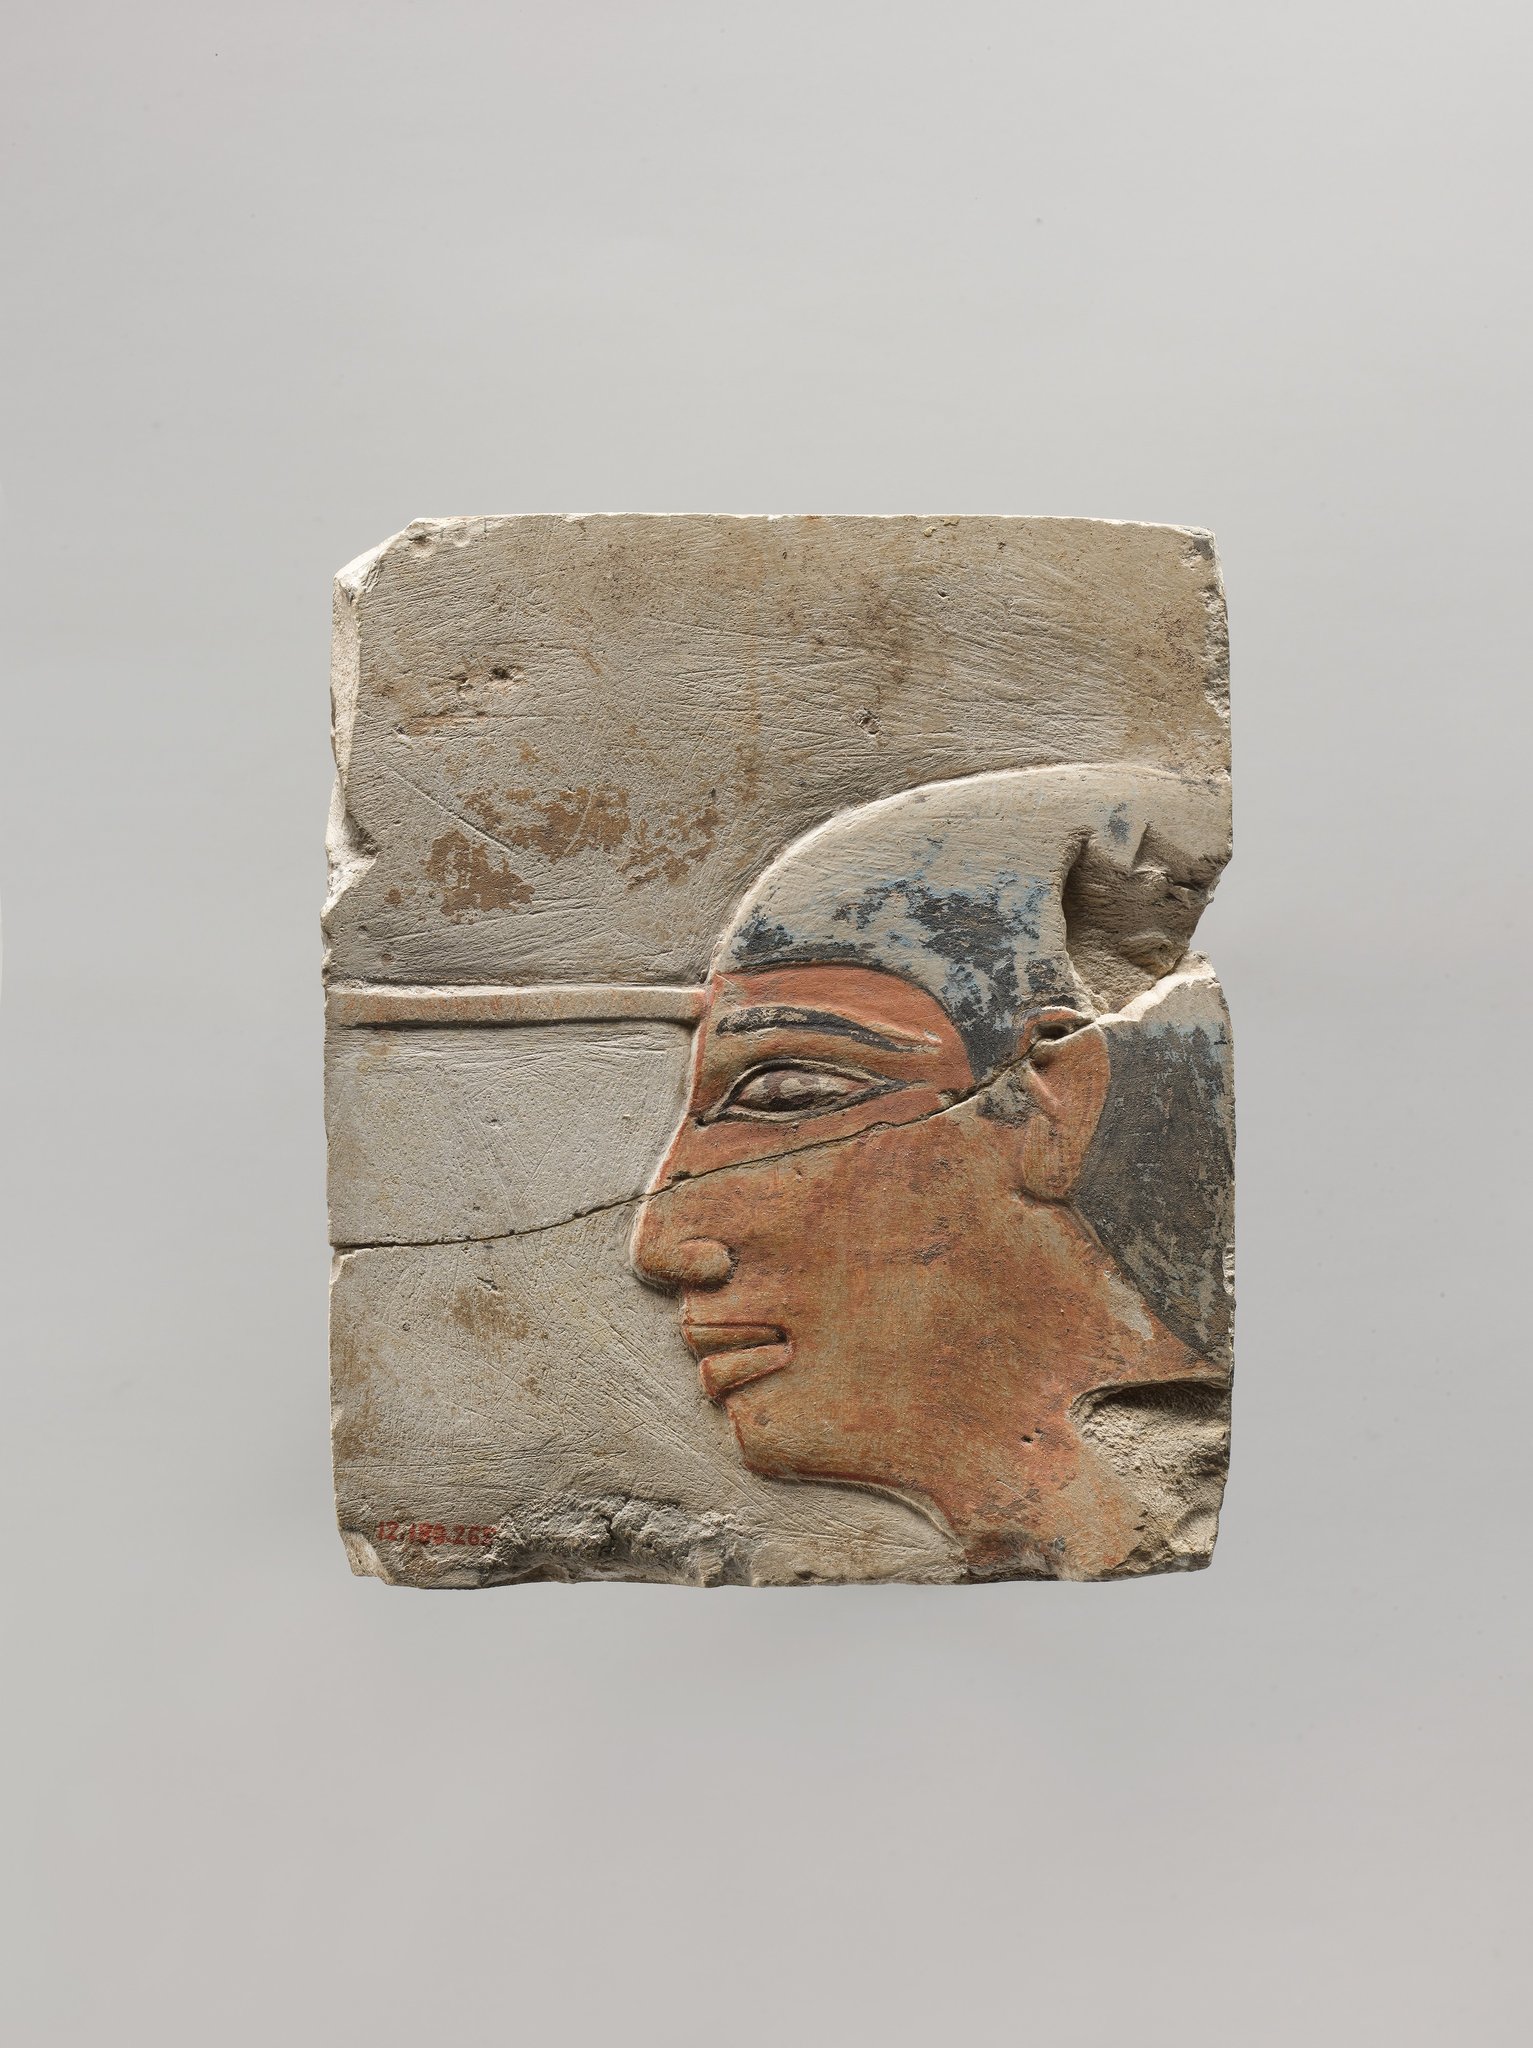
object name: relief, tomb of dagi repair stone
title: Relief depicting the head of a scribe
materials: limestone, paint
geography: egypt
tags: human figures